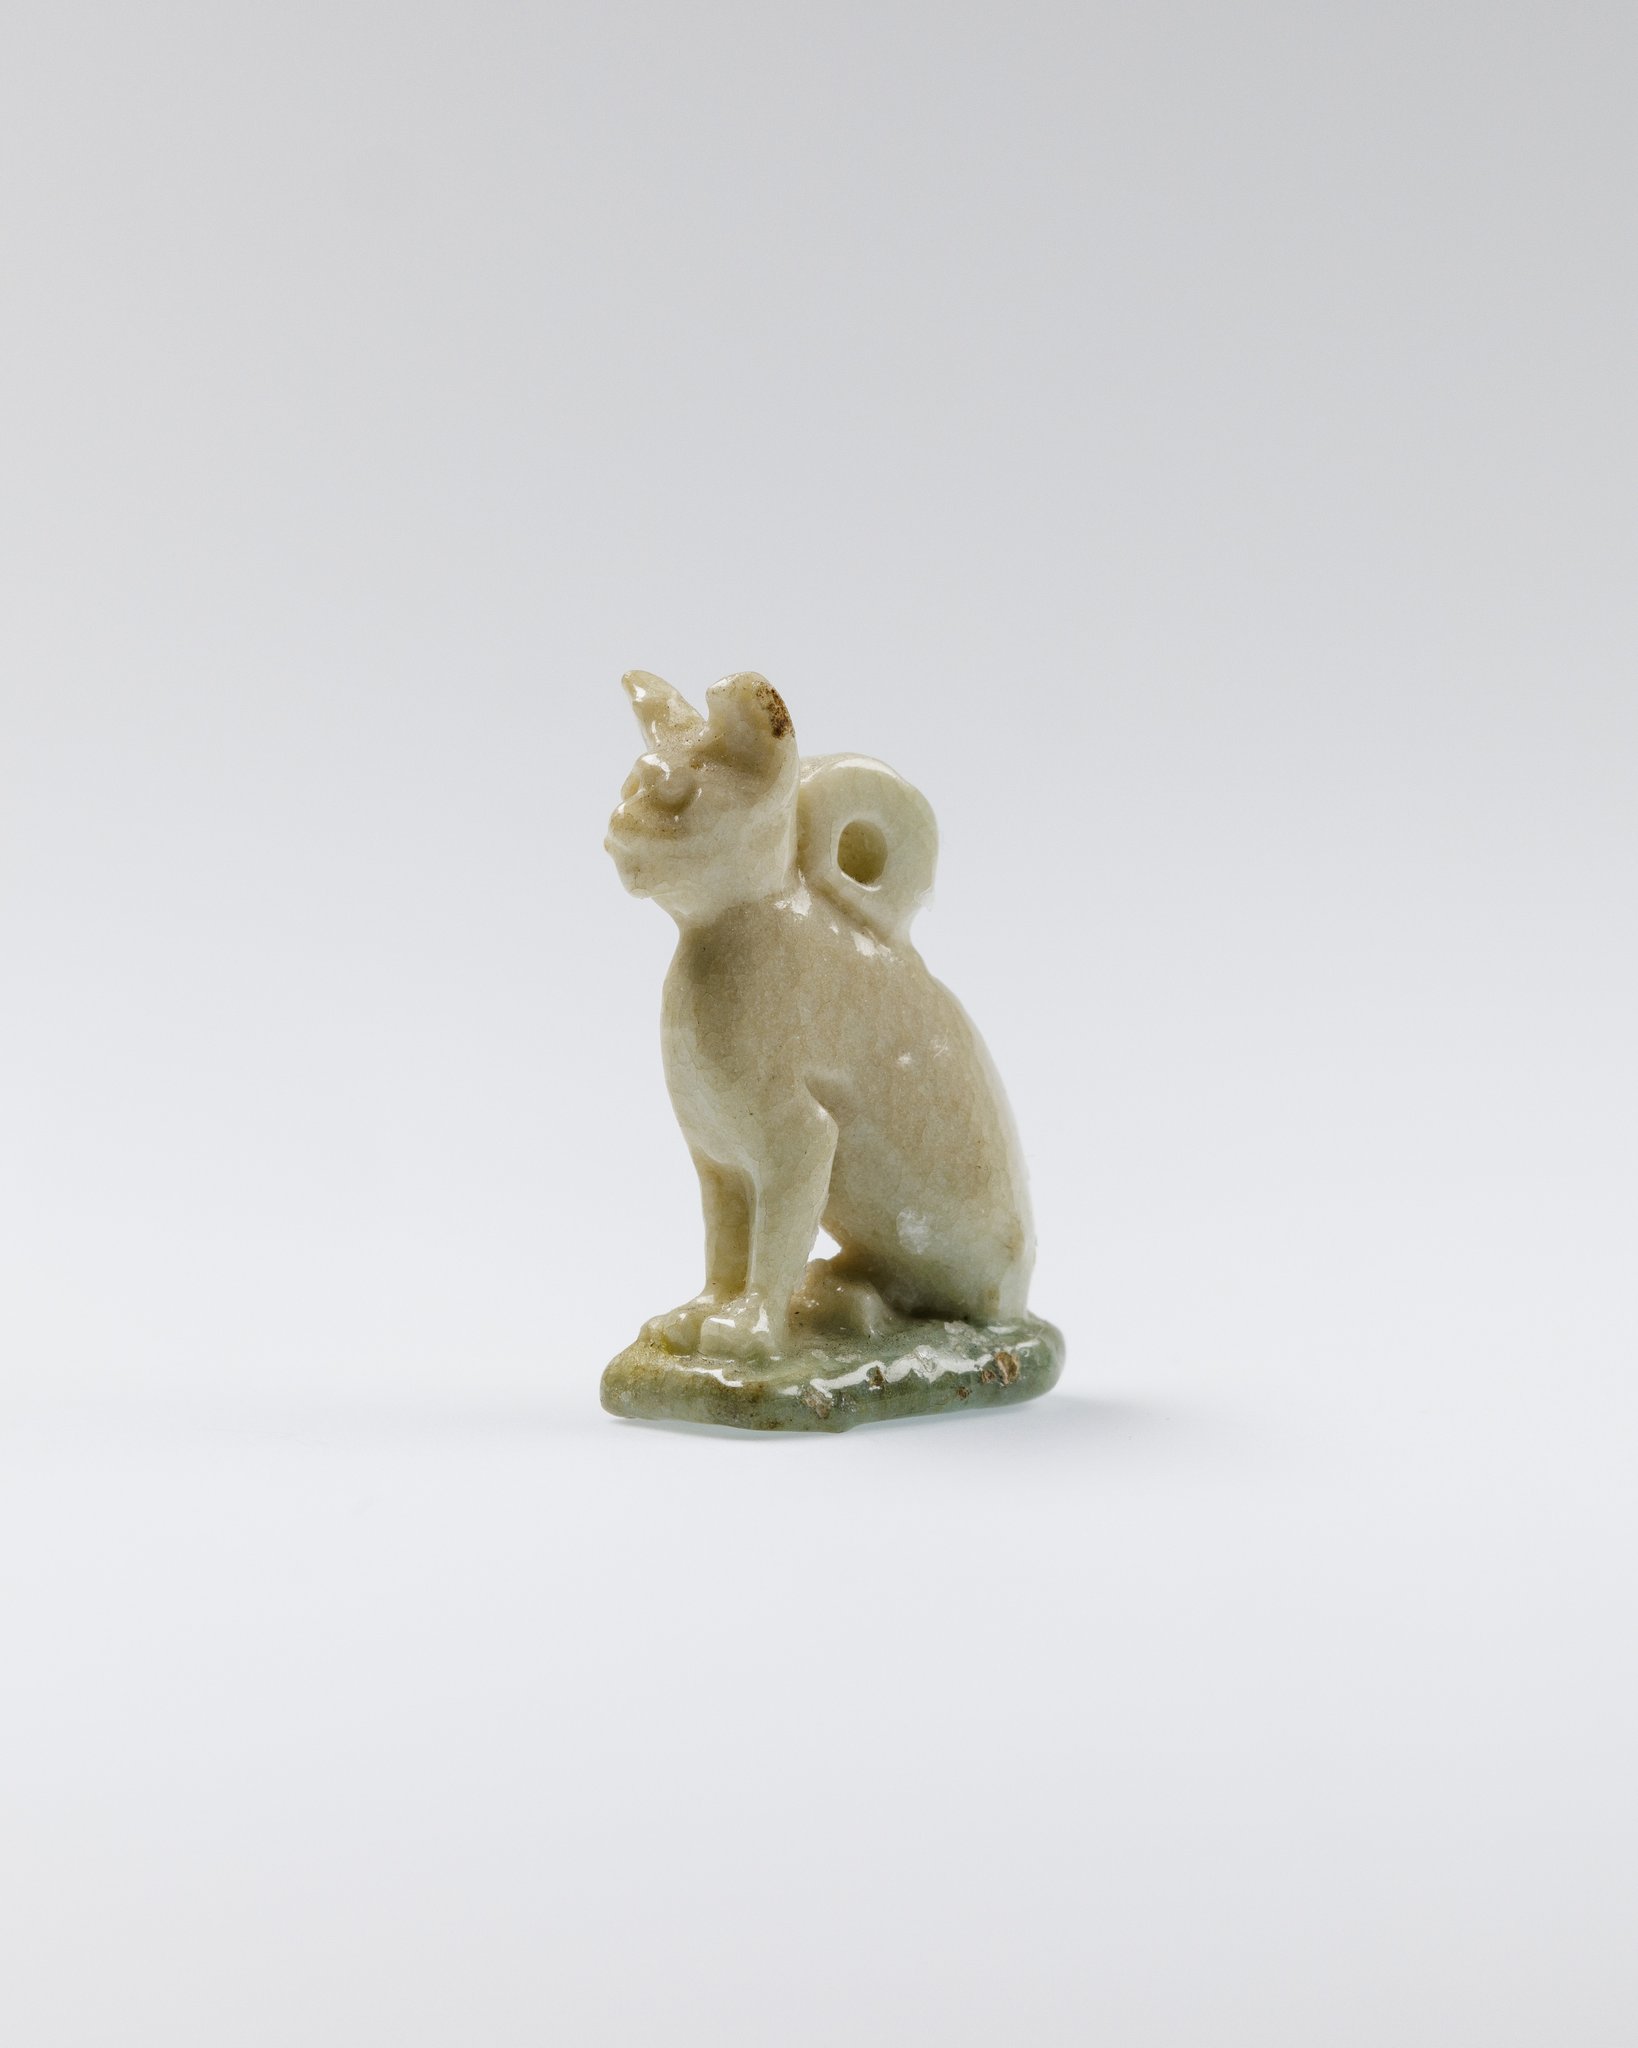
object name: amulet, cat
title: Cat amulet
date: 664-525 BCE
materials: faience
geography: egypt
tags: cats